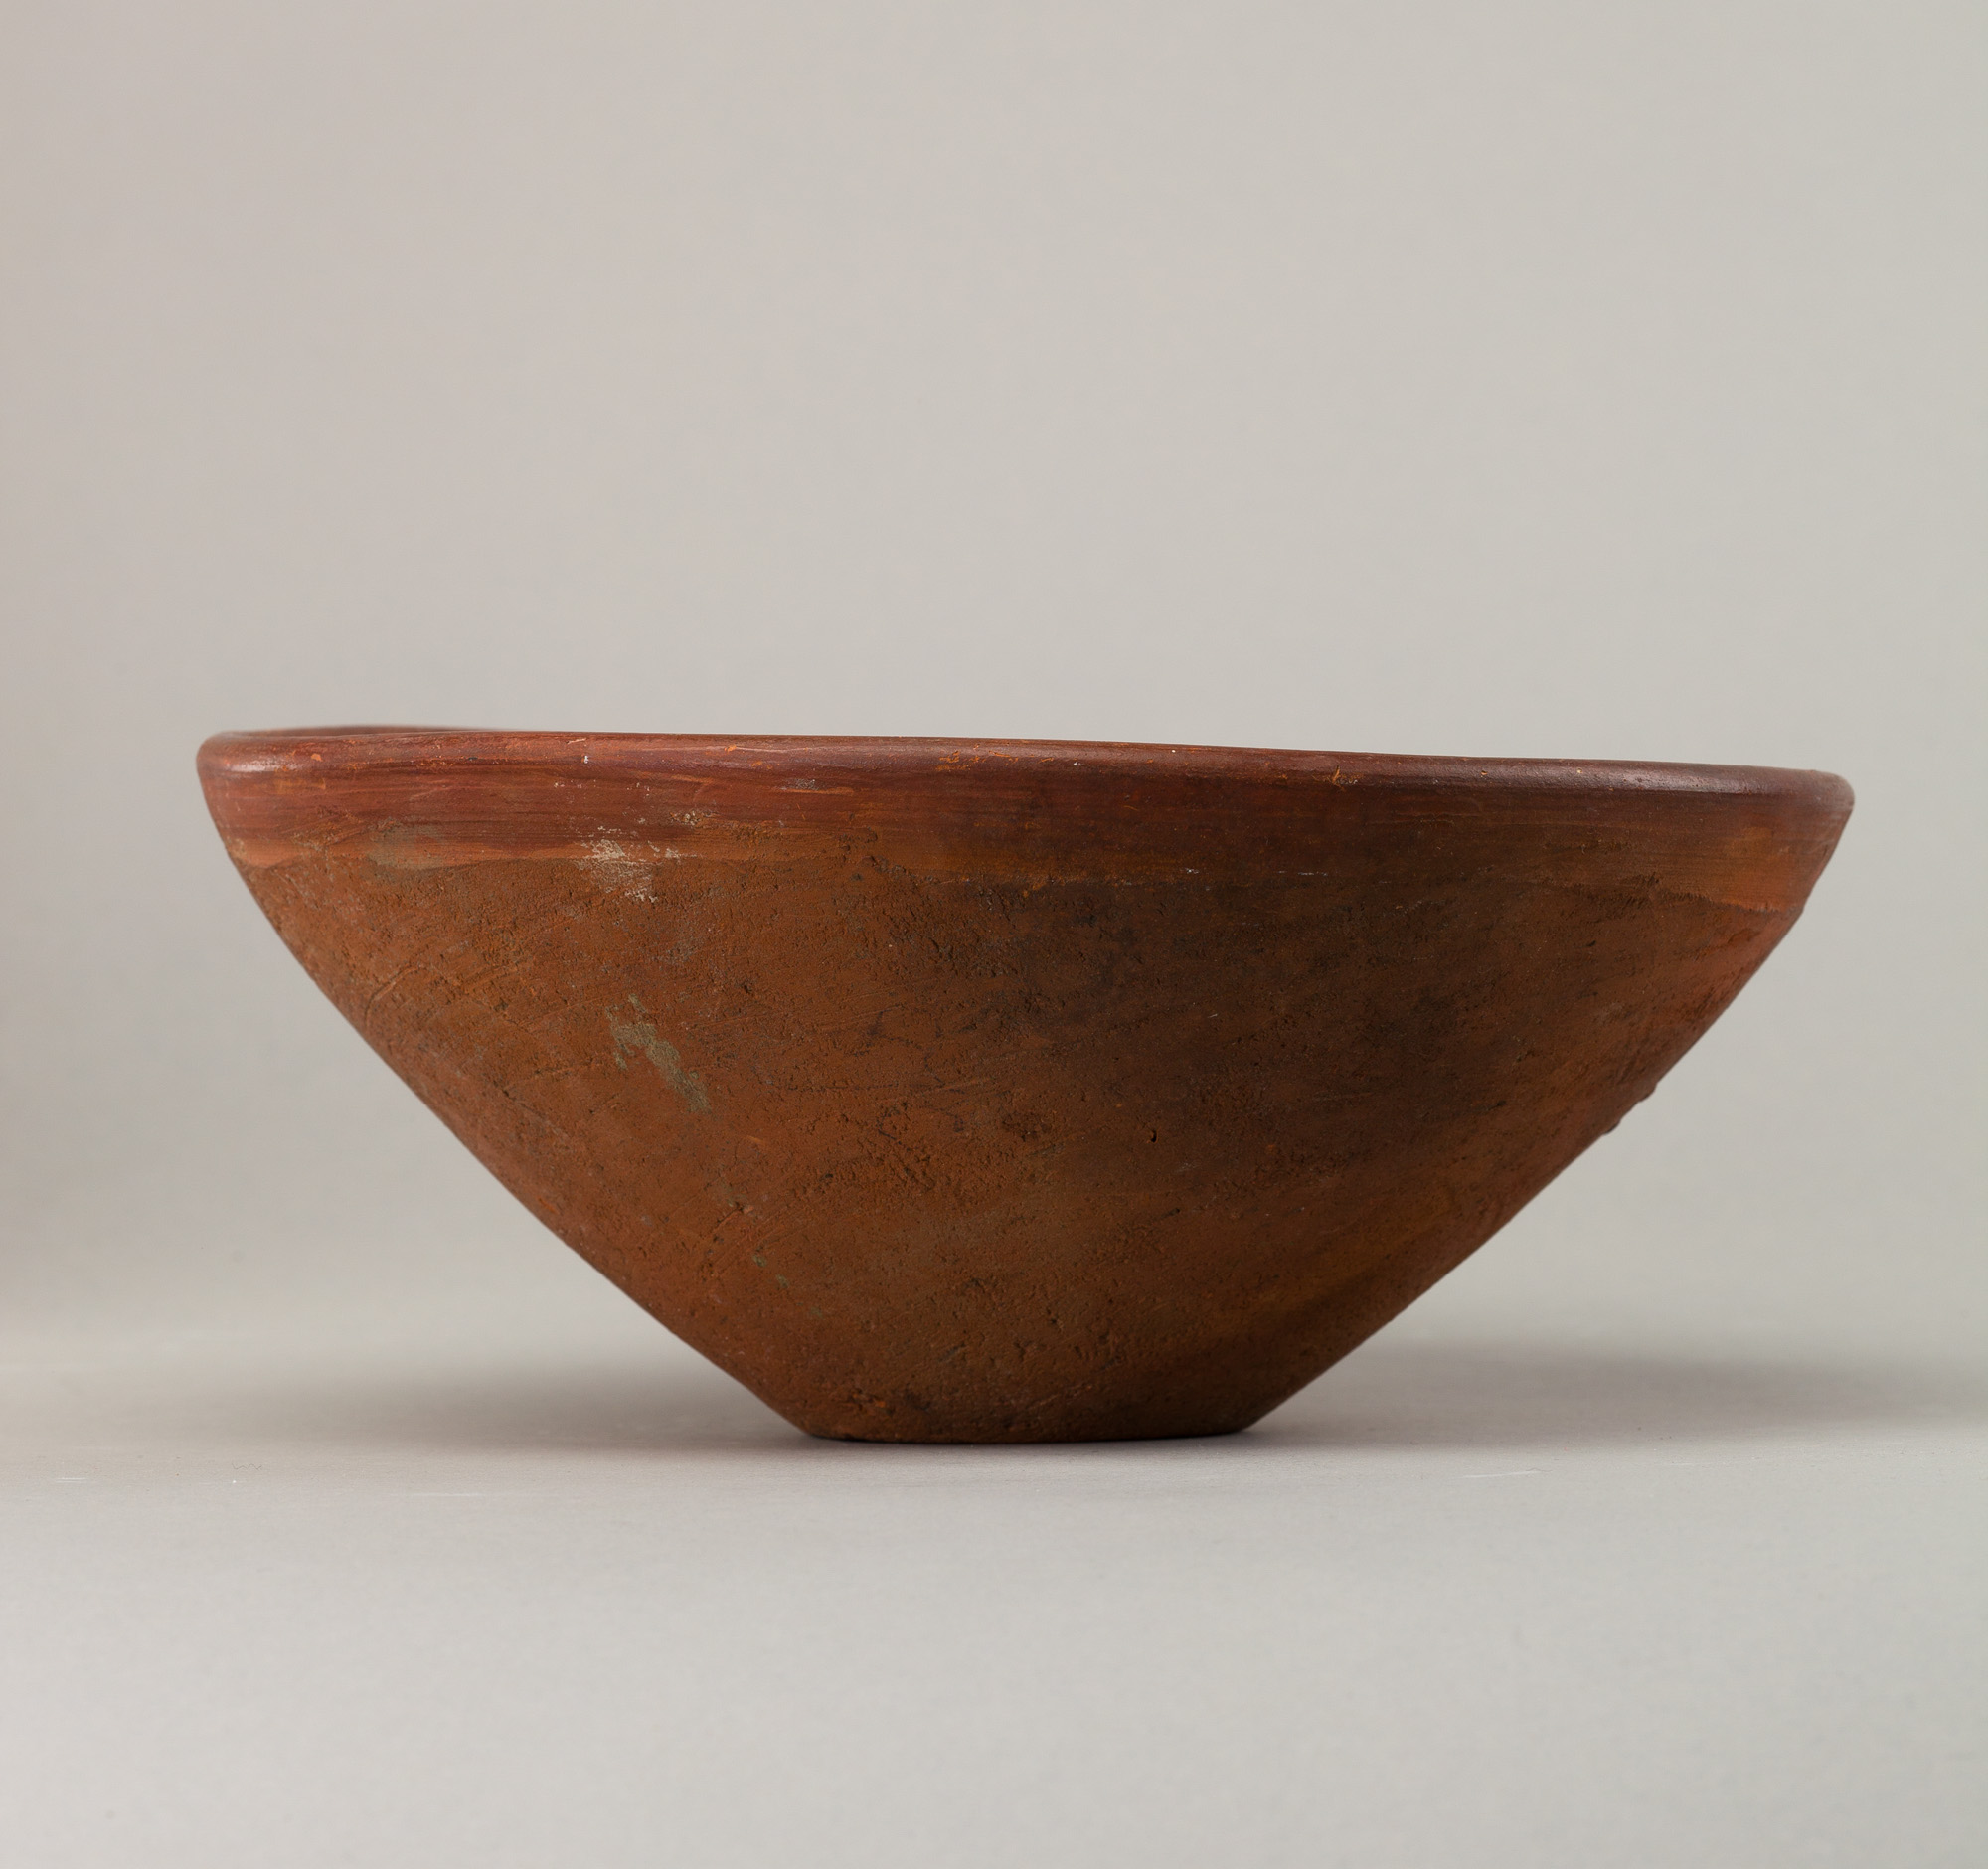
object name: bowl, shallow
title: Shallow bowl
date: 3850-2960 BCE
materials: pottery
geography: egypt